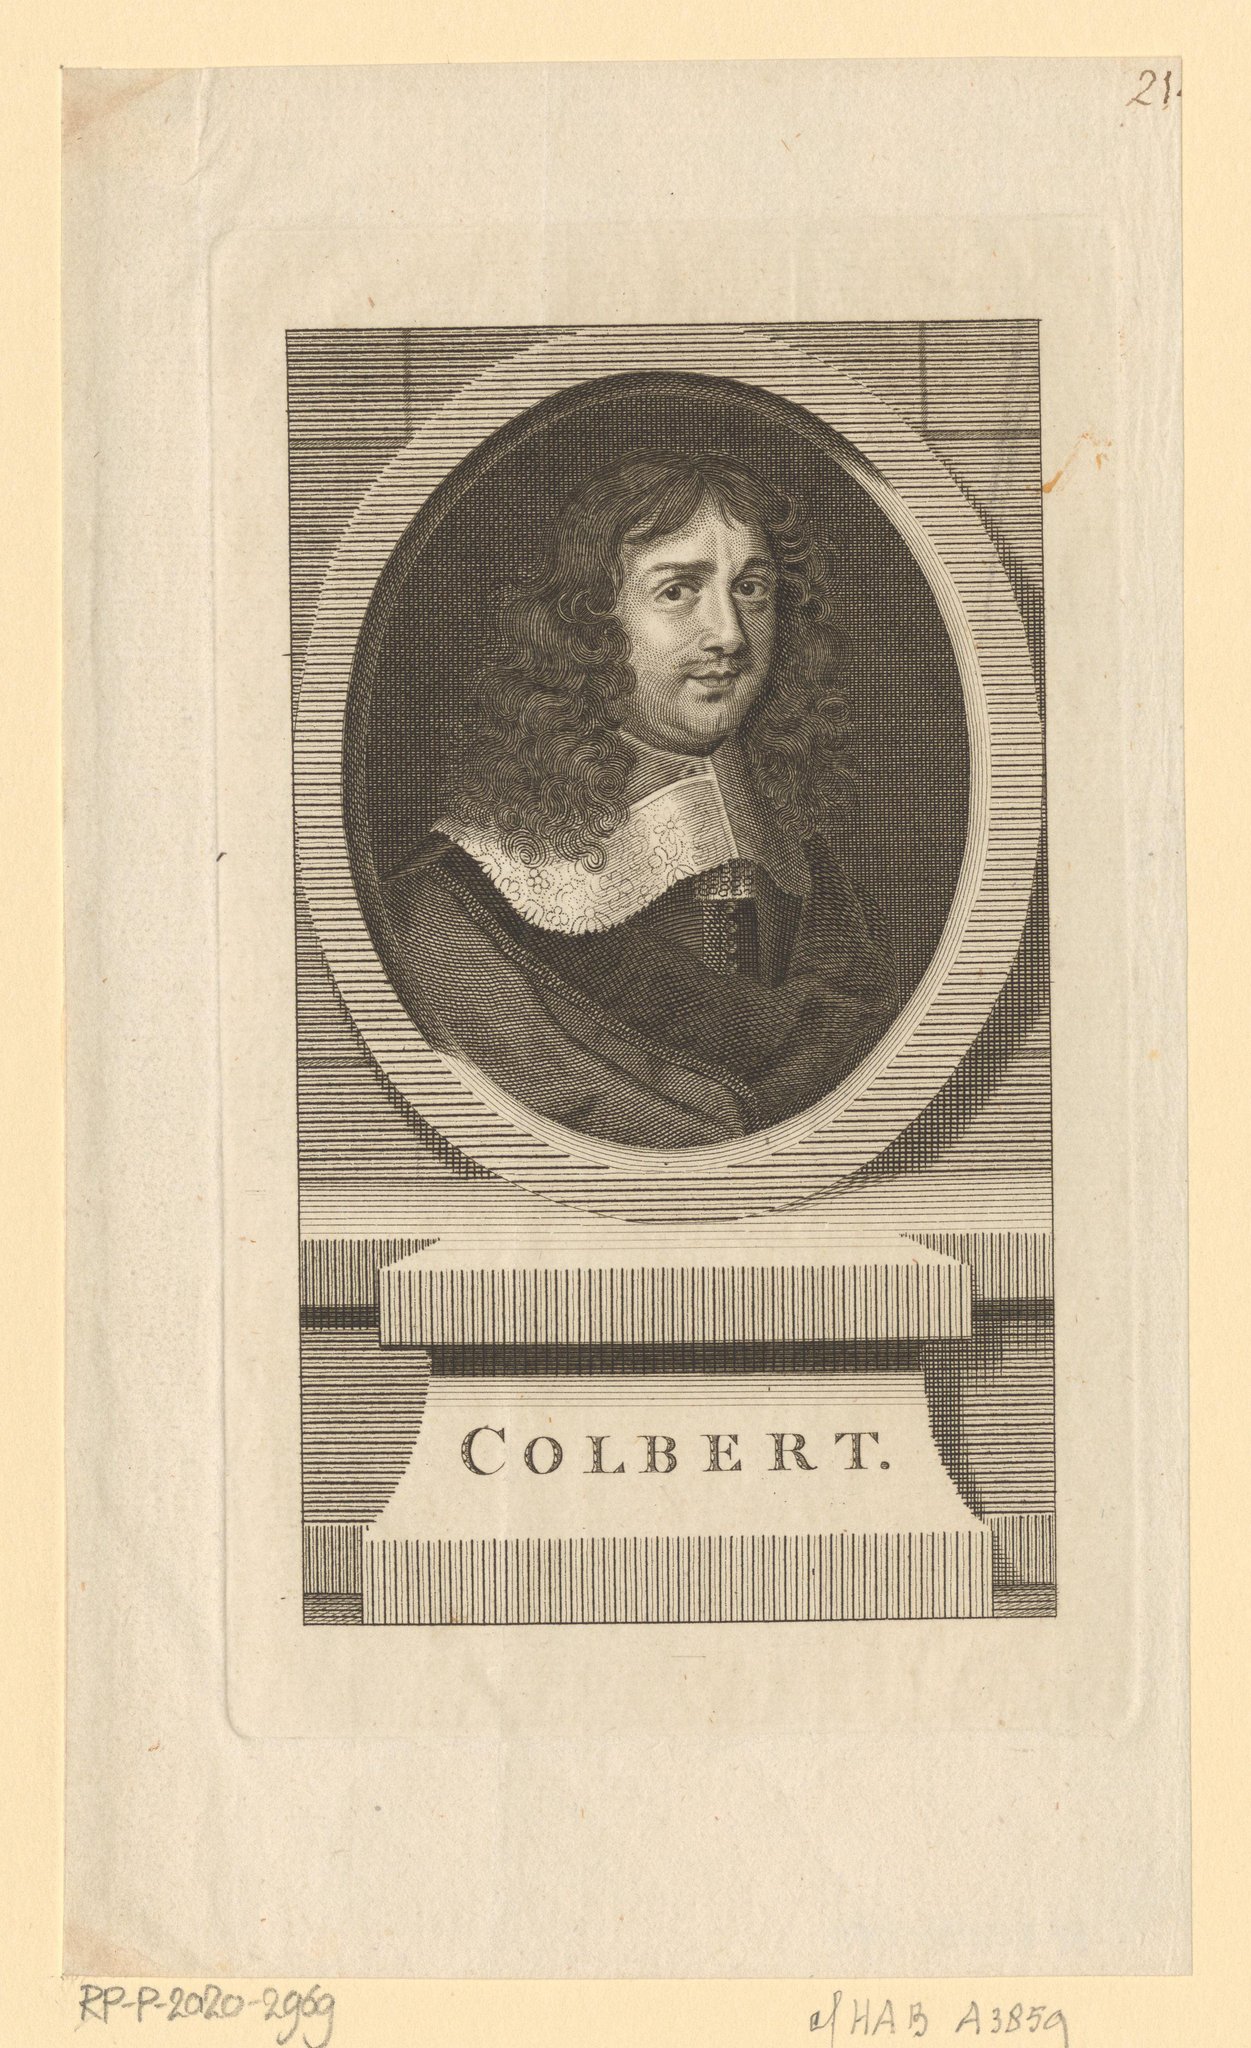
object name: print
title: Portret van Jean-Baptiste Colbert de Seignelay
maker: Anonymous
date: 1700-1799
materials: paper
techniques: engraving, etching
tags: politician, jean-baptiste colbert de seignelay, historical persons